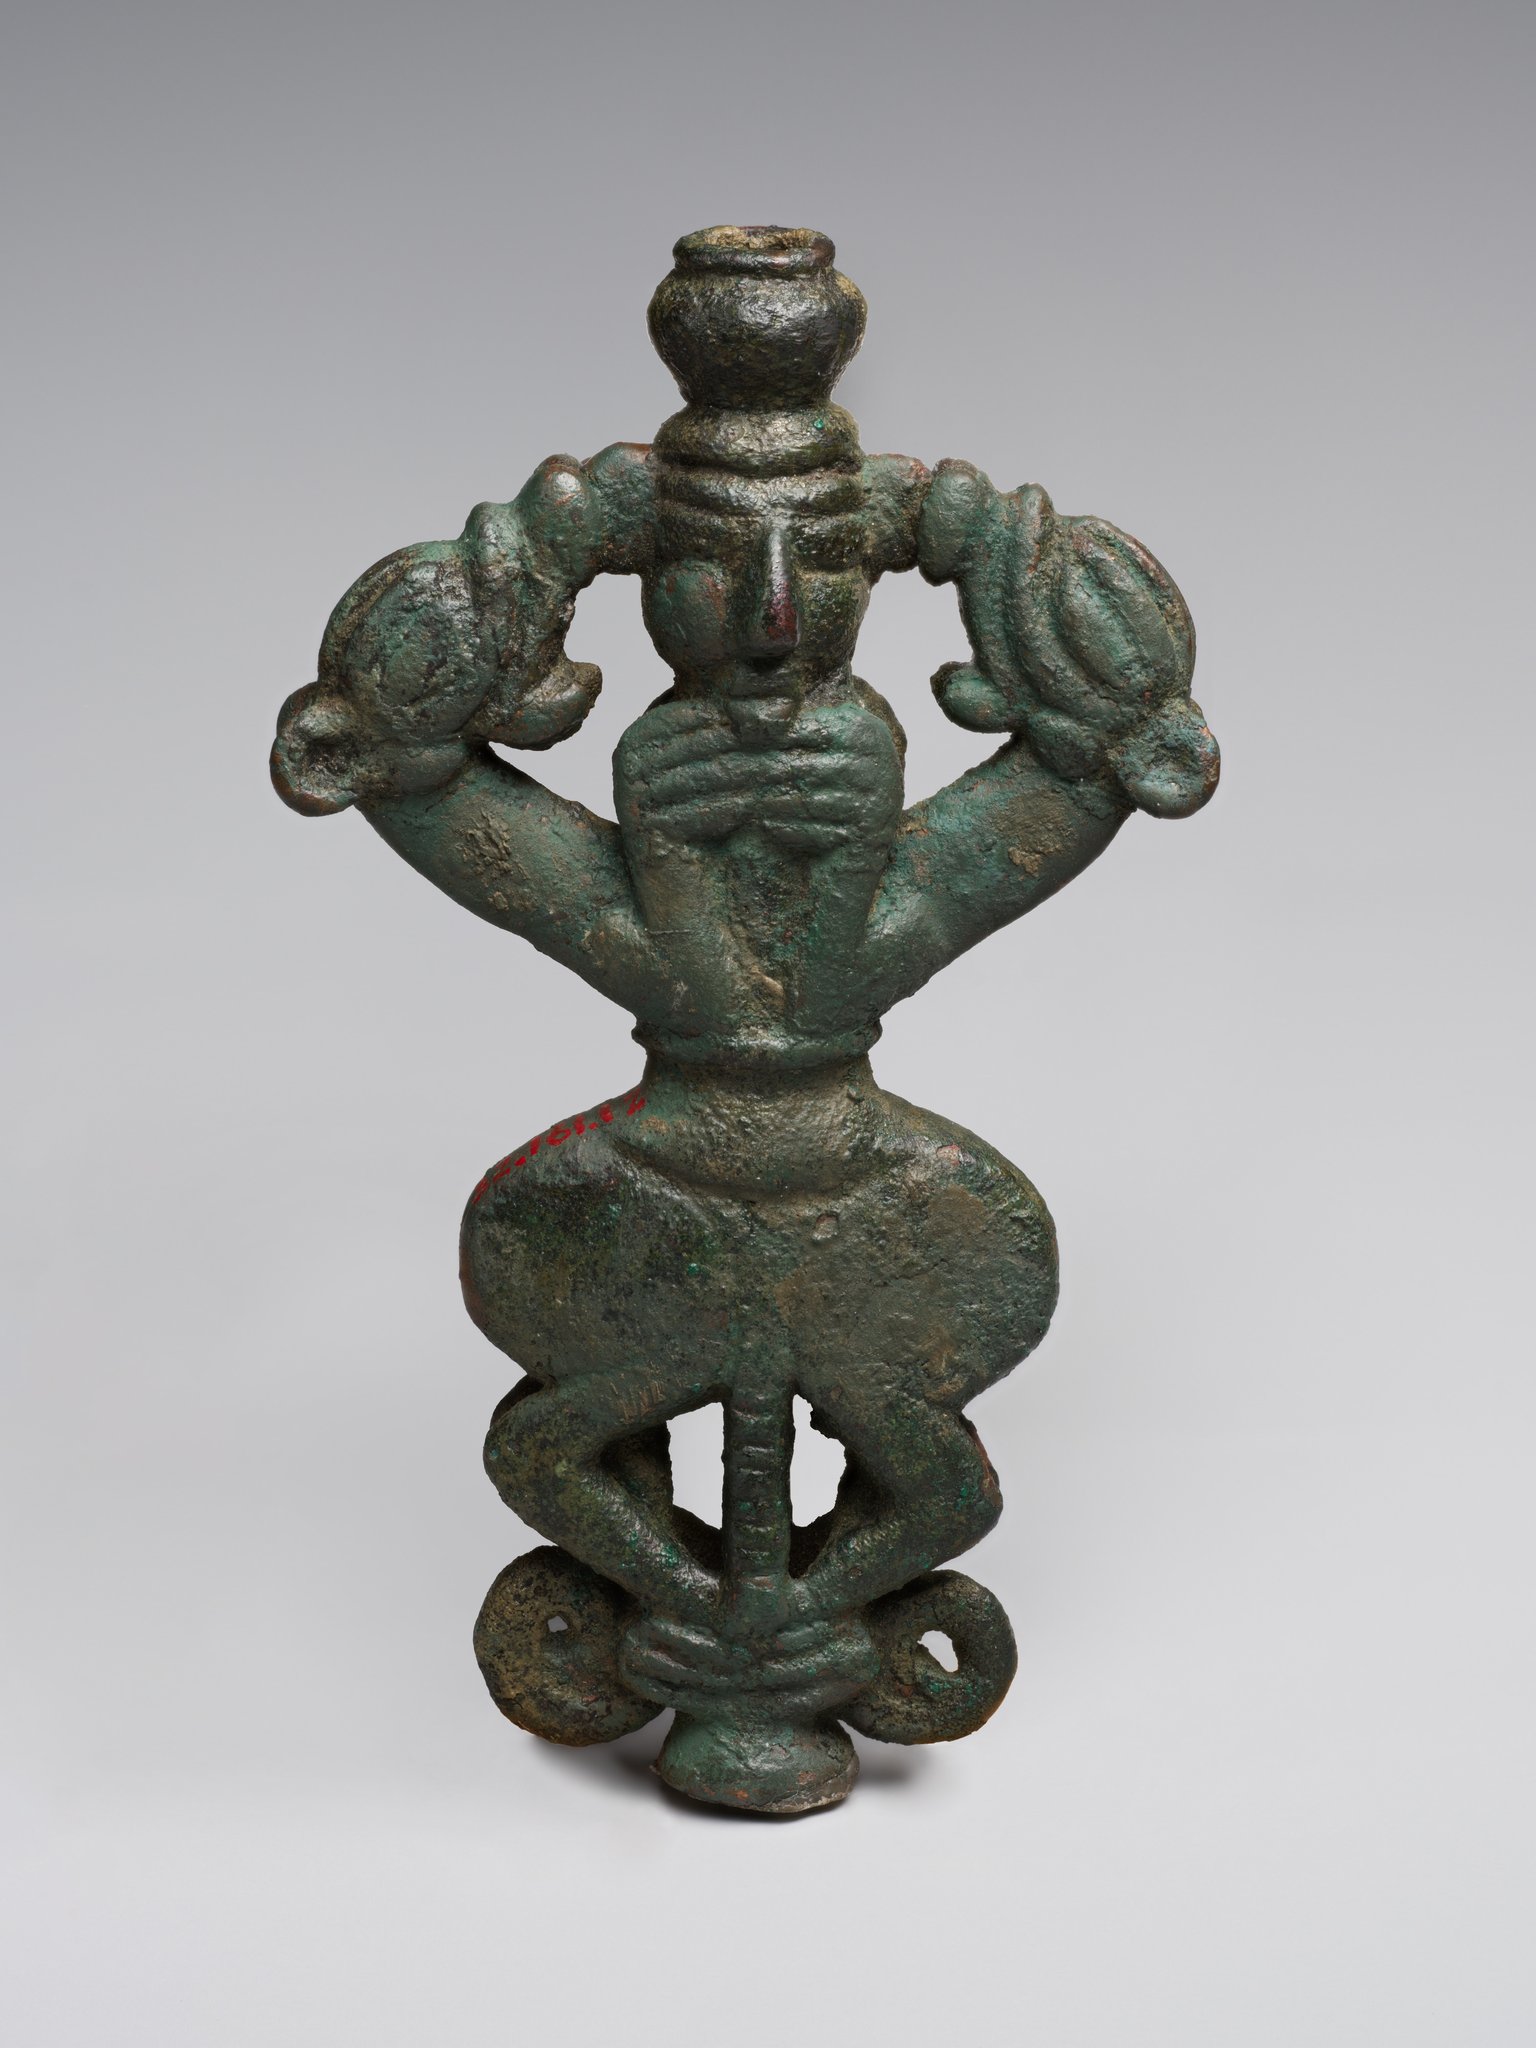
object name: standard top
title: Top for standard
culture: iranian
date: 800-601 BCE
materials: bronze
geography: iran, probably from luristan